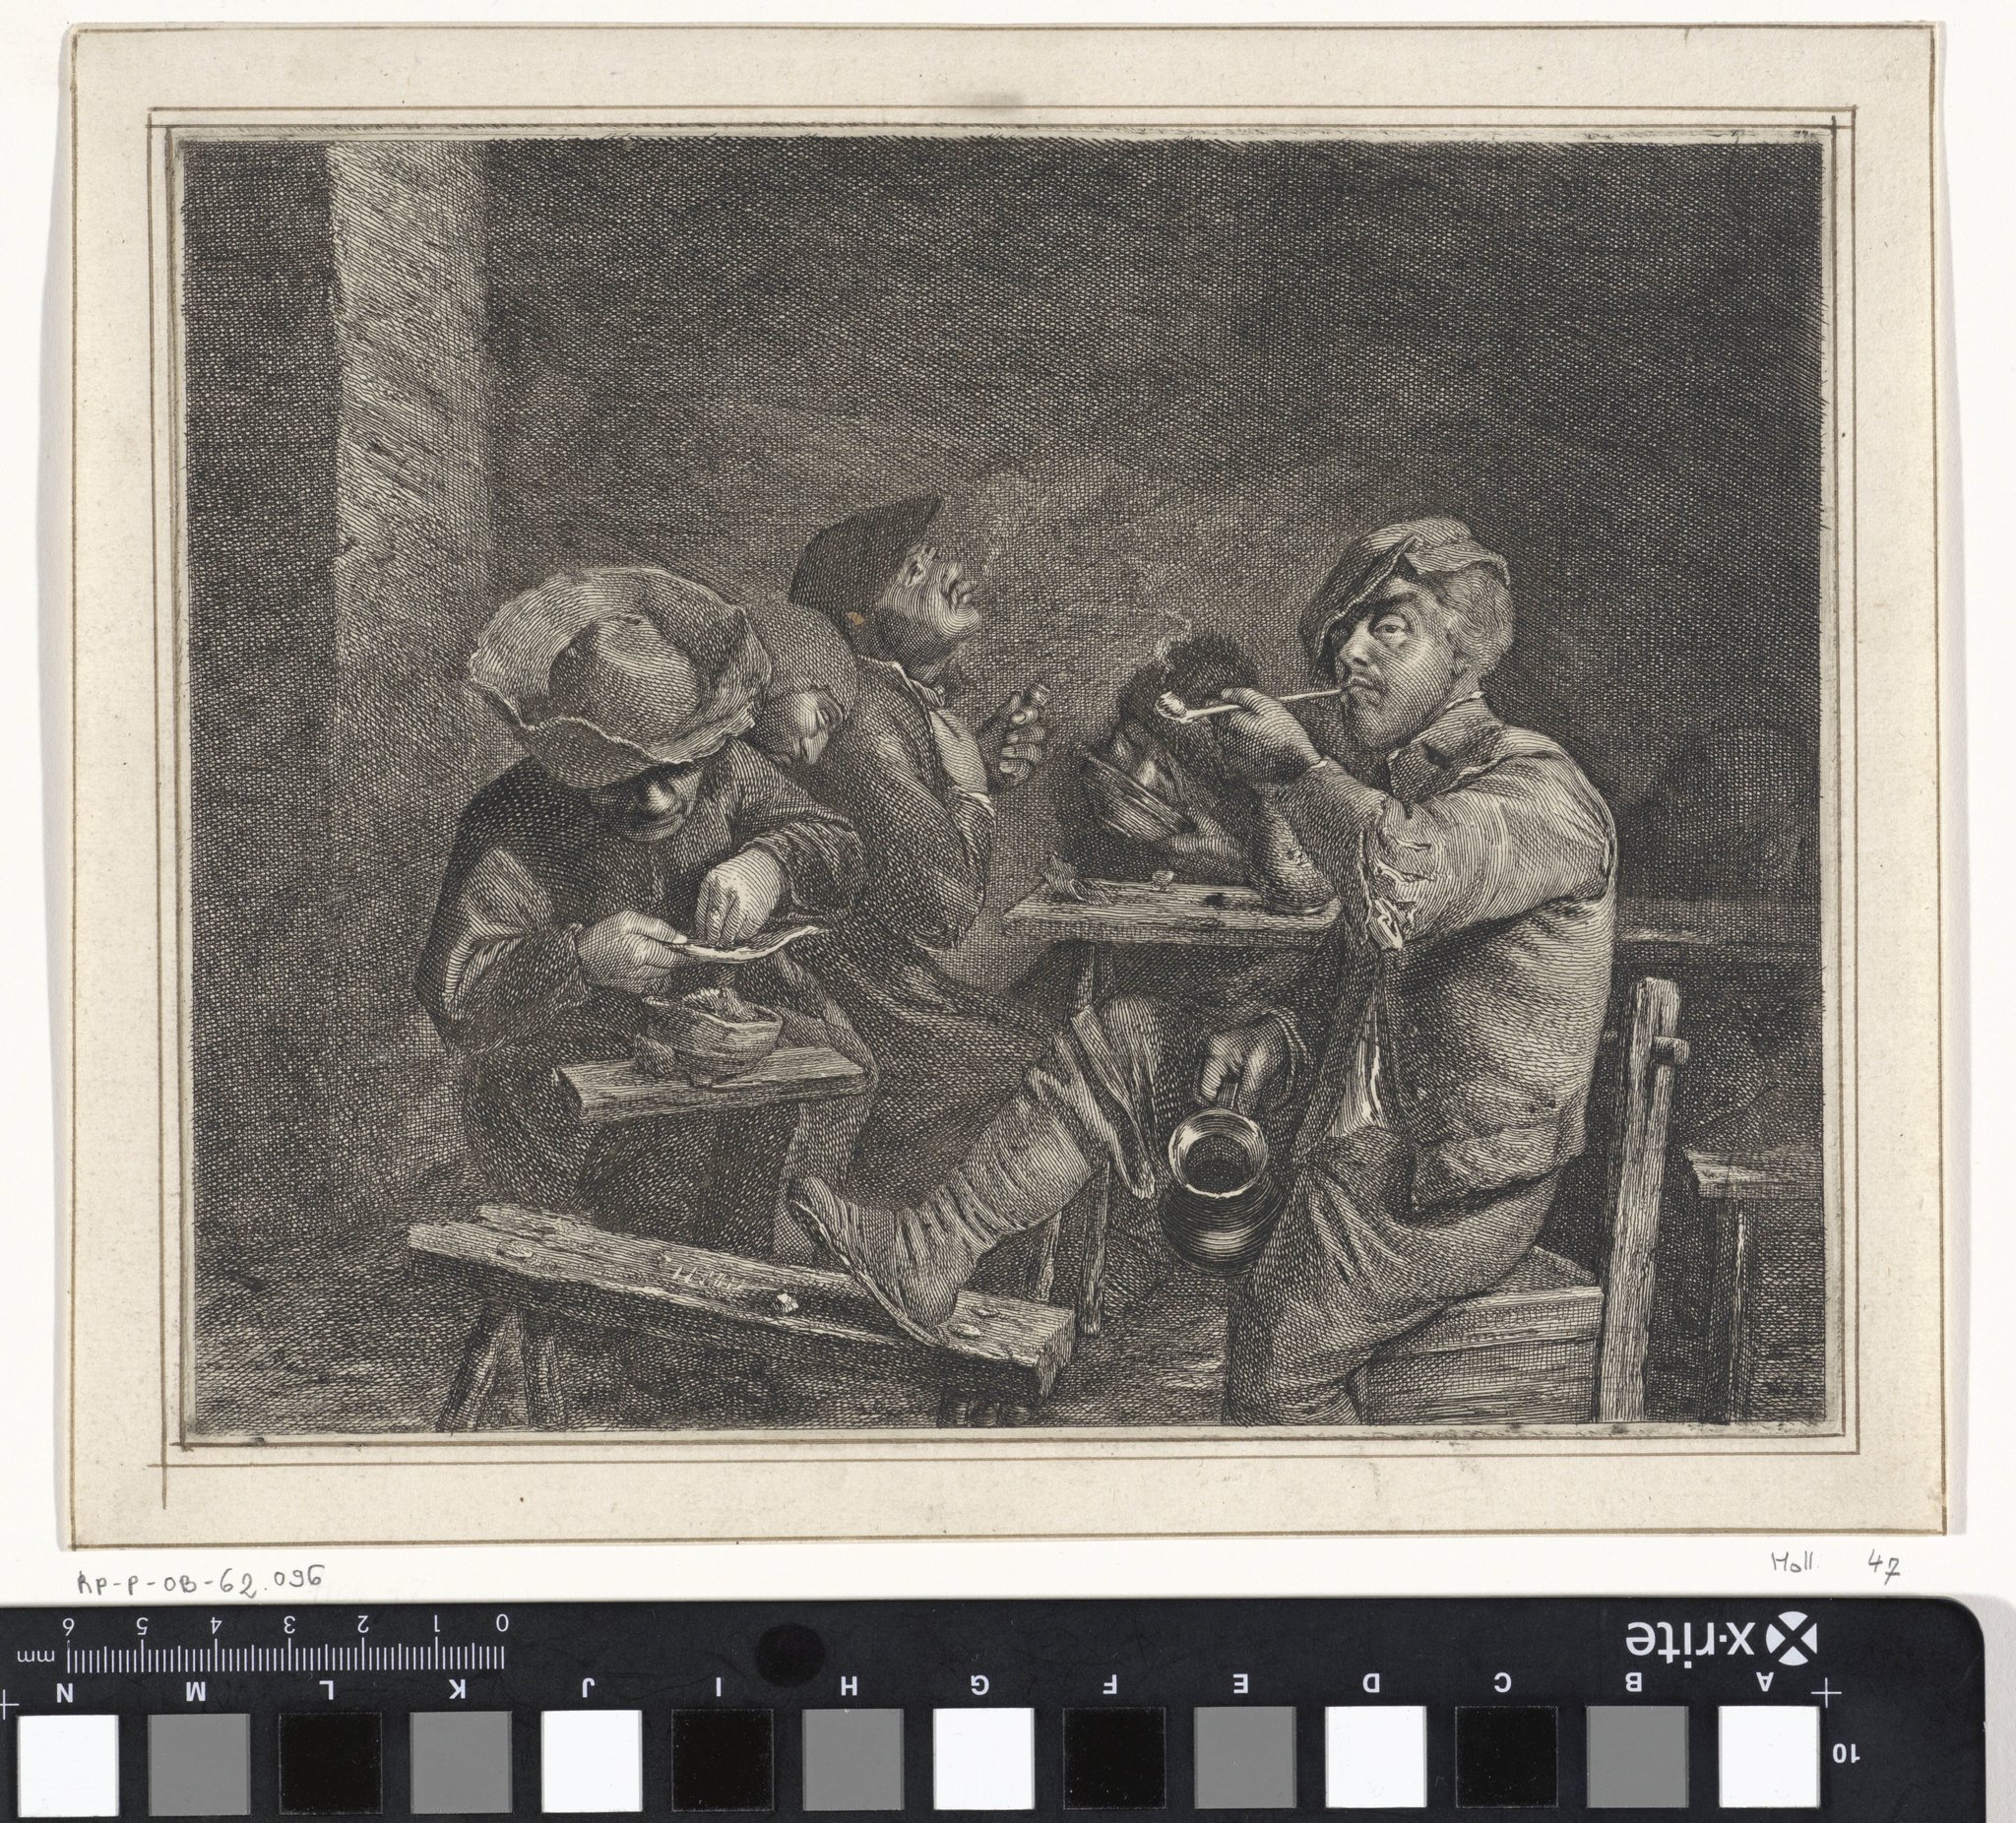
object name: print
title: Rokende mannen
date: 1638-1658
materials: paper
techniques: engraving, etching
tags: inn, coffee-house, public house, etc., pipe ~ tobacco, eating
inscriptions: collector's mark: Lugt 240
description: In een herberg bevindt zich een groep mannen waarvan er twee een pijp roken. Een derde man lijkt tabak te prepareren voor gebruik. Op de achtergrond eet een man met zijn mond uit een schaal.